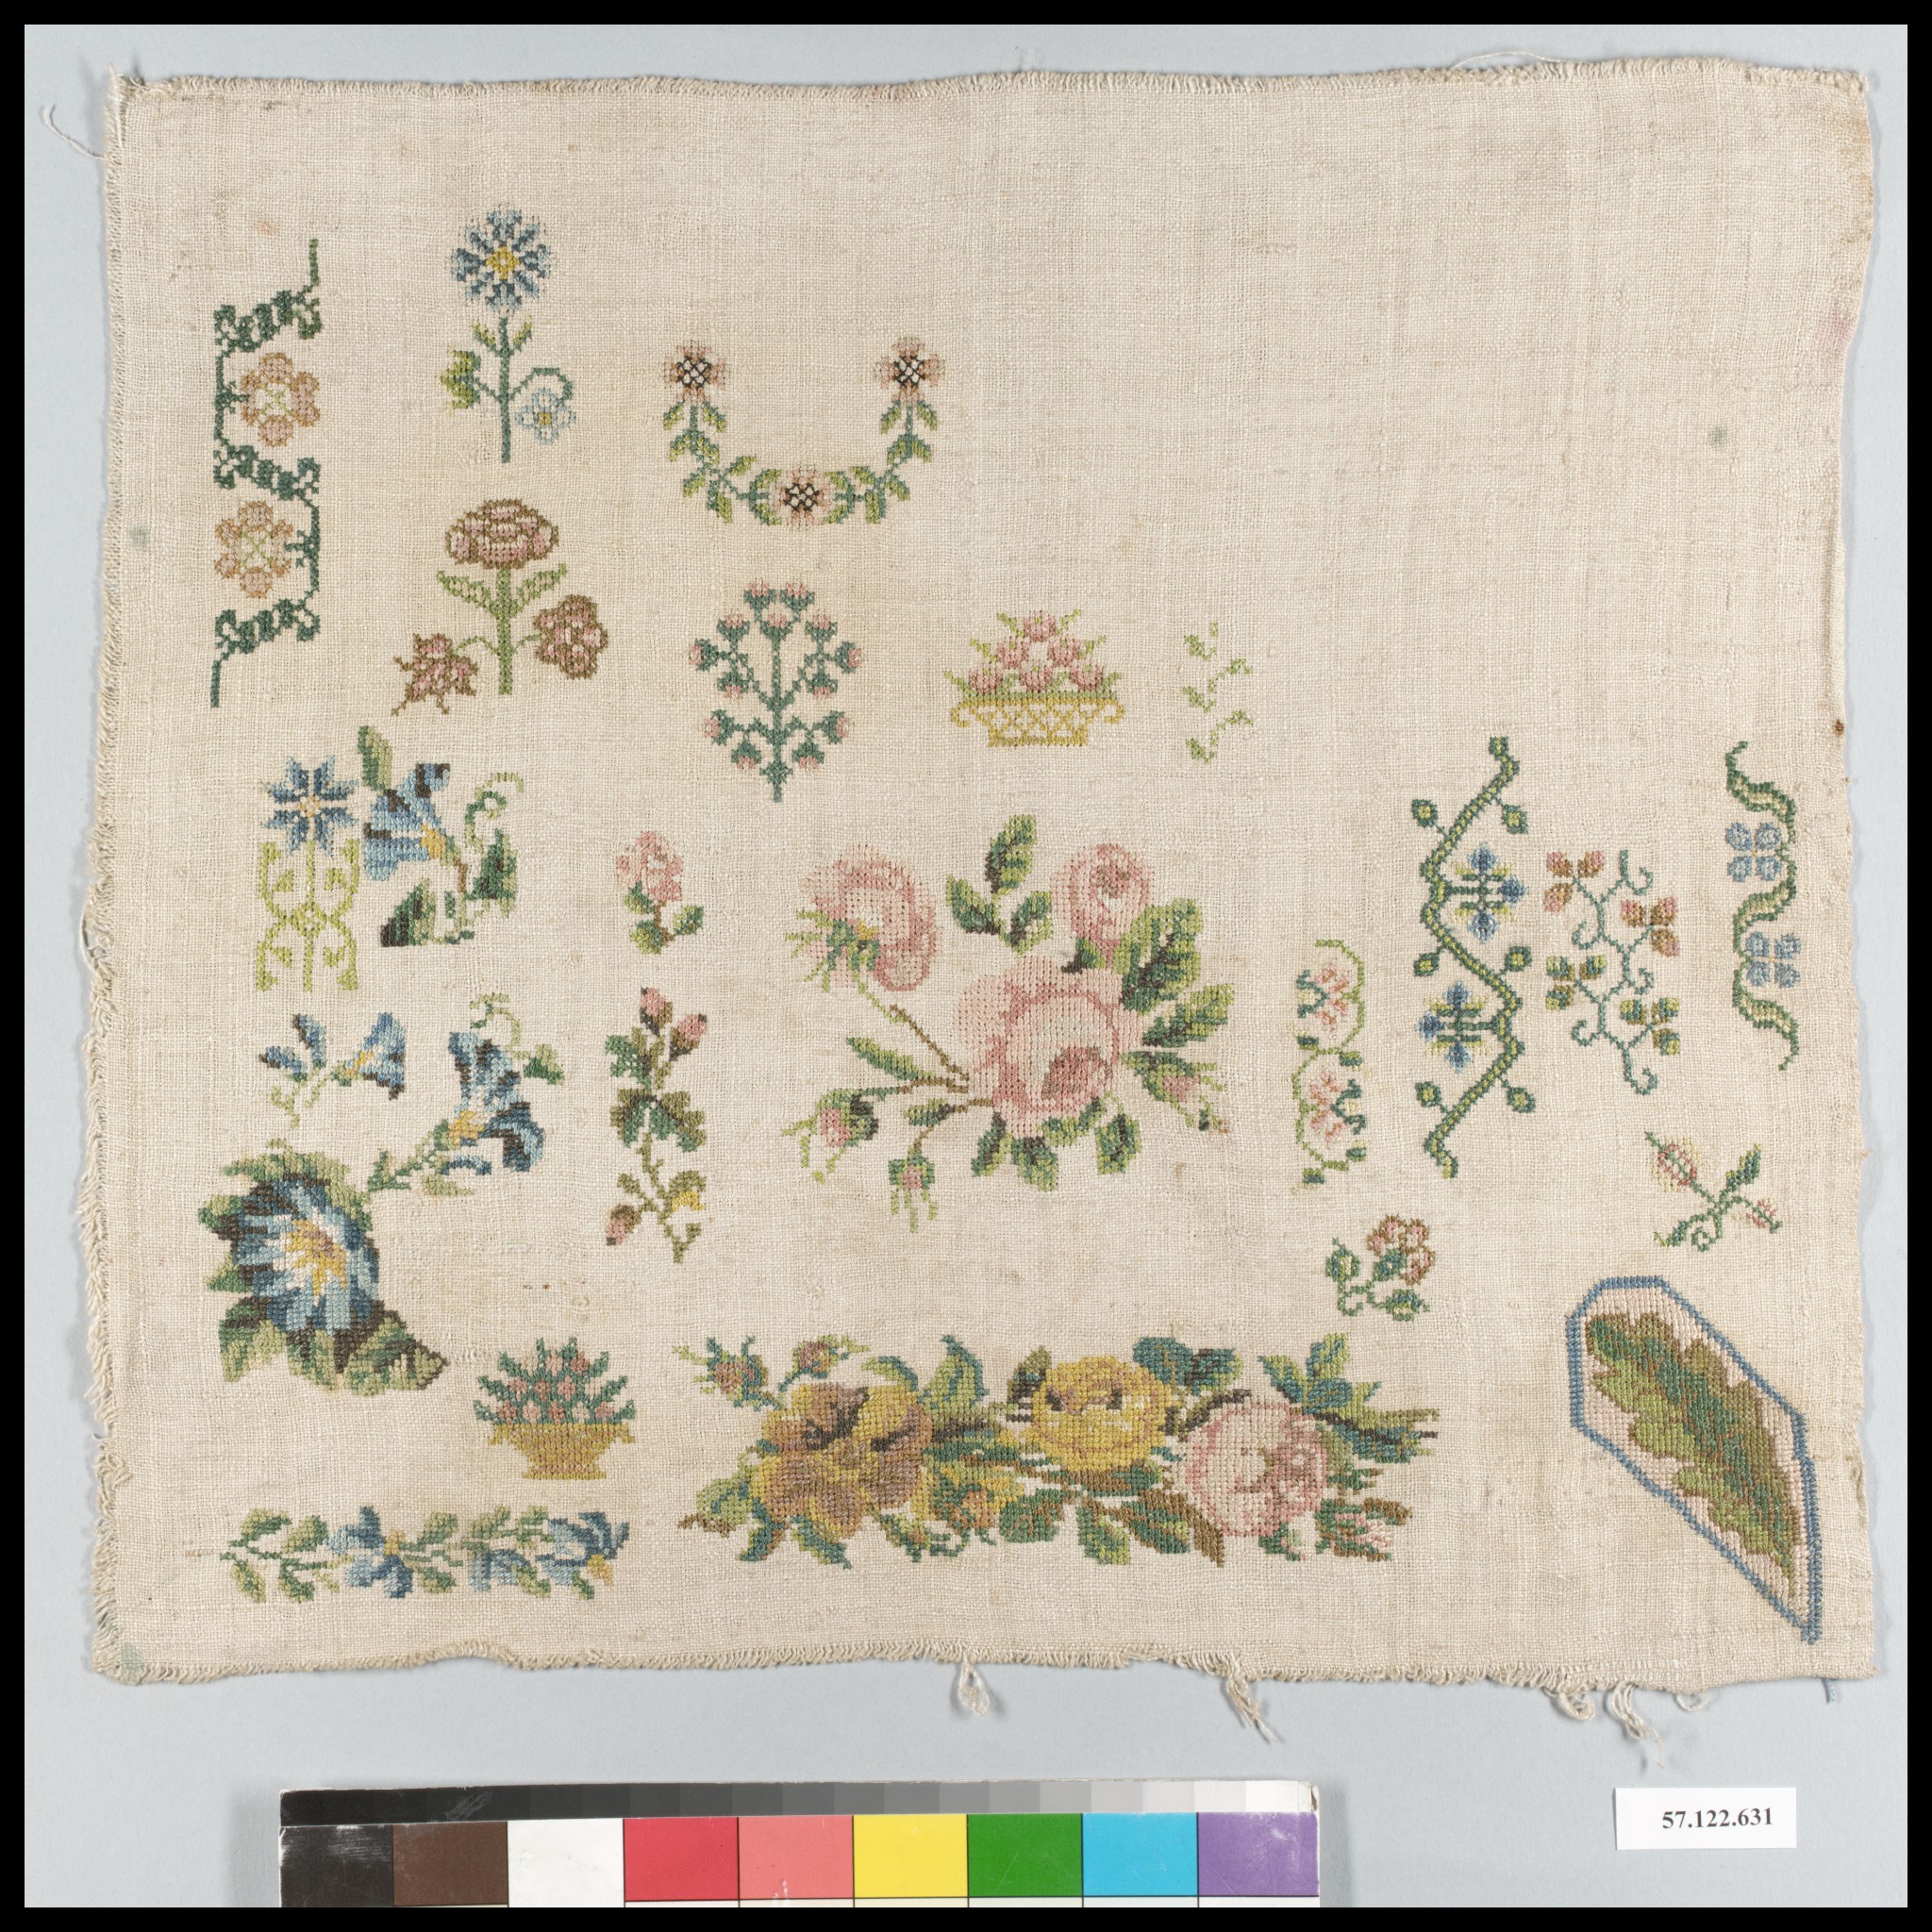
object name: sampler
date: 1801-1900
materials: linen, silk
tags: flowers,leaves